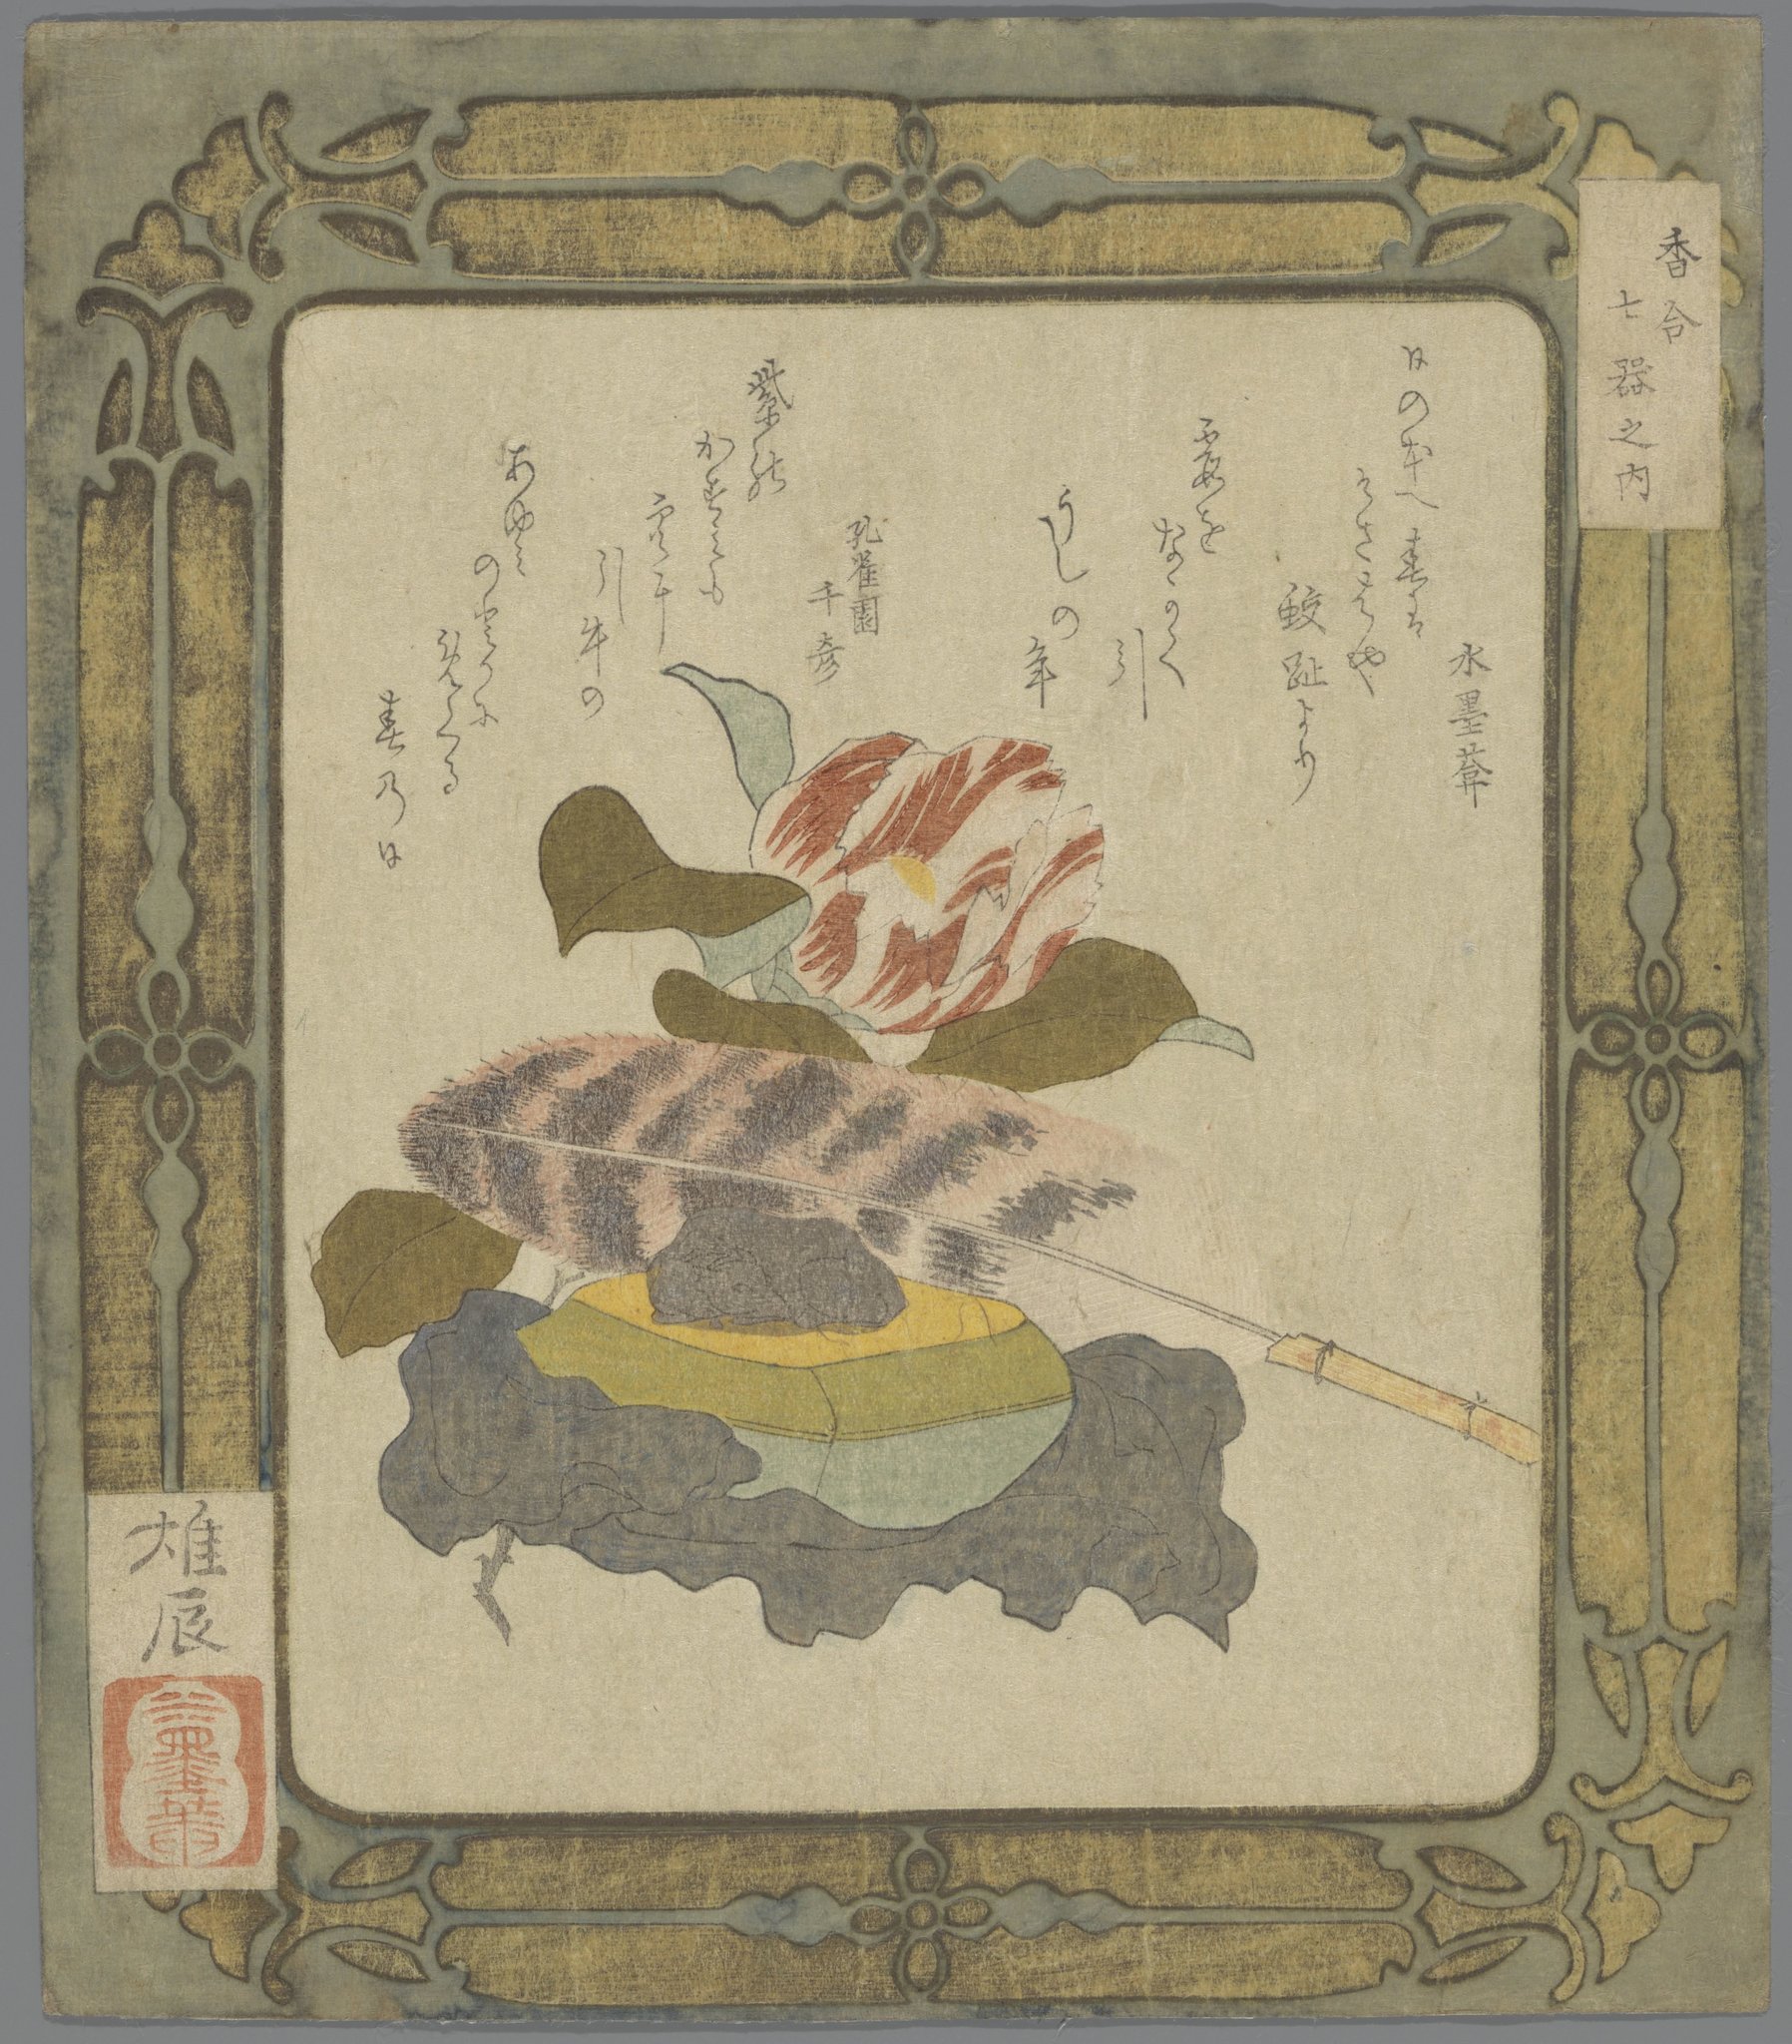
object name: surimono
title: Seven utensils for the incense competition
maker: suibokuan yushin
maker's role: print maker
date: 1829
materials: paper, pigment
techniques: blind stamped, woodcut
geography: japan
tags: still life of miscellaneous objects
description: 2021 is the Year of the Ox. He is depicted reclining on the yellow lid of the incense box. Stroking a figurine of an ox was thought to bring good fortune. Behind the ox is the feather of a falcon, which was used in an incense game. Because of its striped pattern, the feather can also refer to the Year of the Tiger, which follows the Year of the Ox.